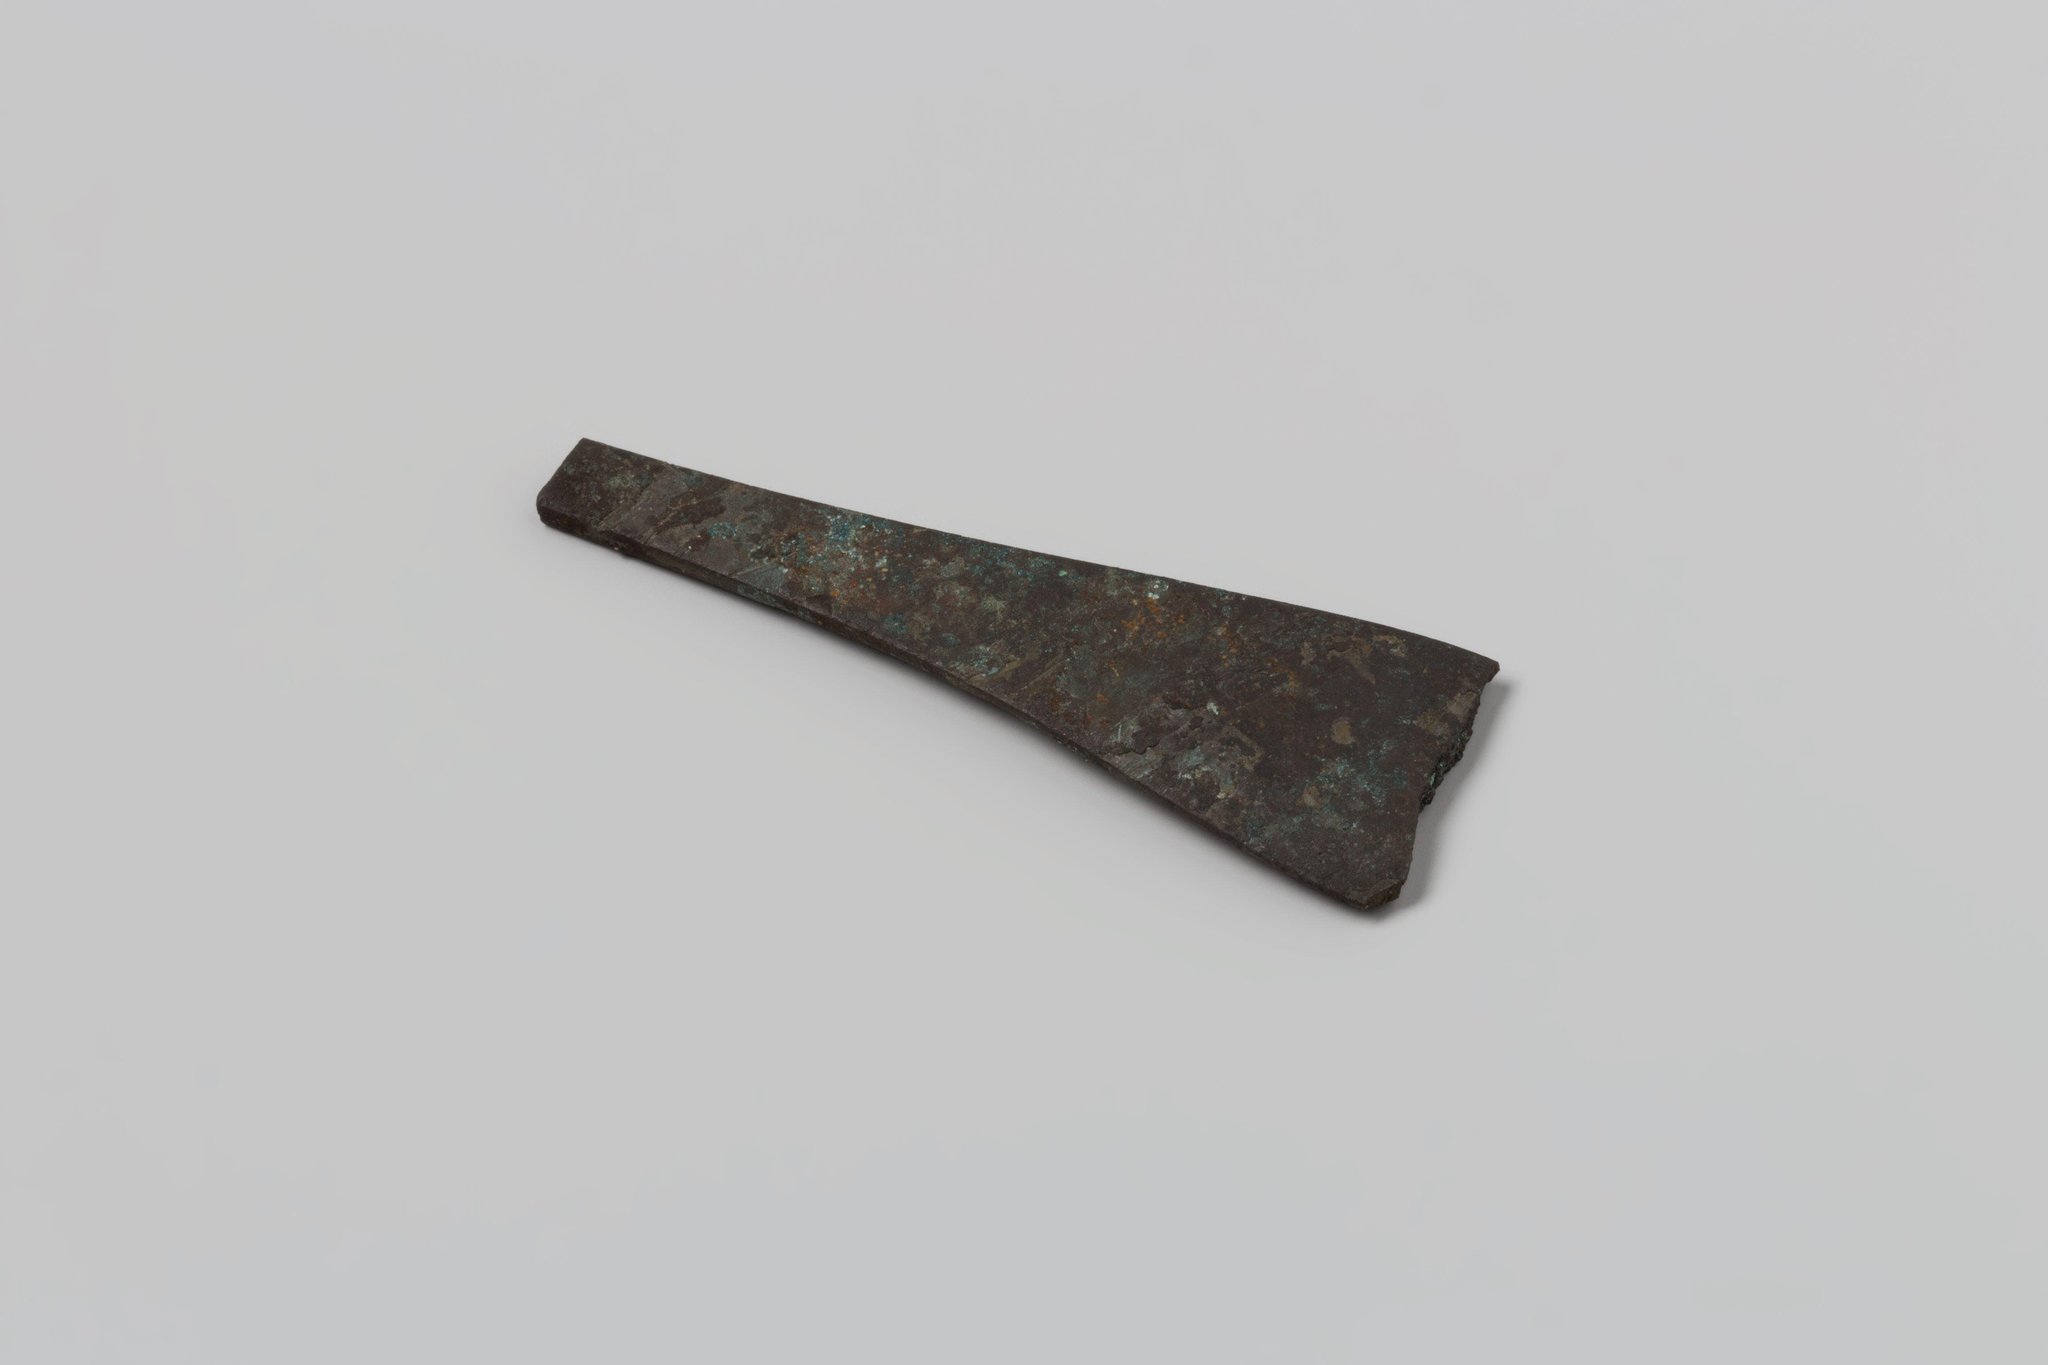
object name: spoon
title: Fragment steel van vork of lepel uit het wrak van de Oost-Indiëvaarder Hollandia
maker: Anonymous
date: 1700-1743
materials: copper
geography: netherlands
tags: verenigde oostindische compagnie, hollandia (schip), annet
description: Cutlery, fragment: stem of fork or spoon; fragm, flat, widening.